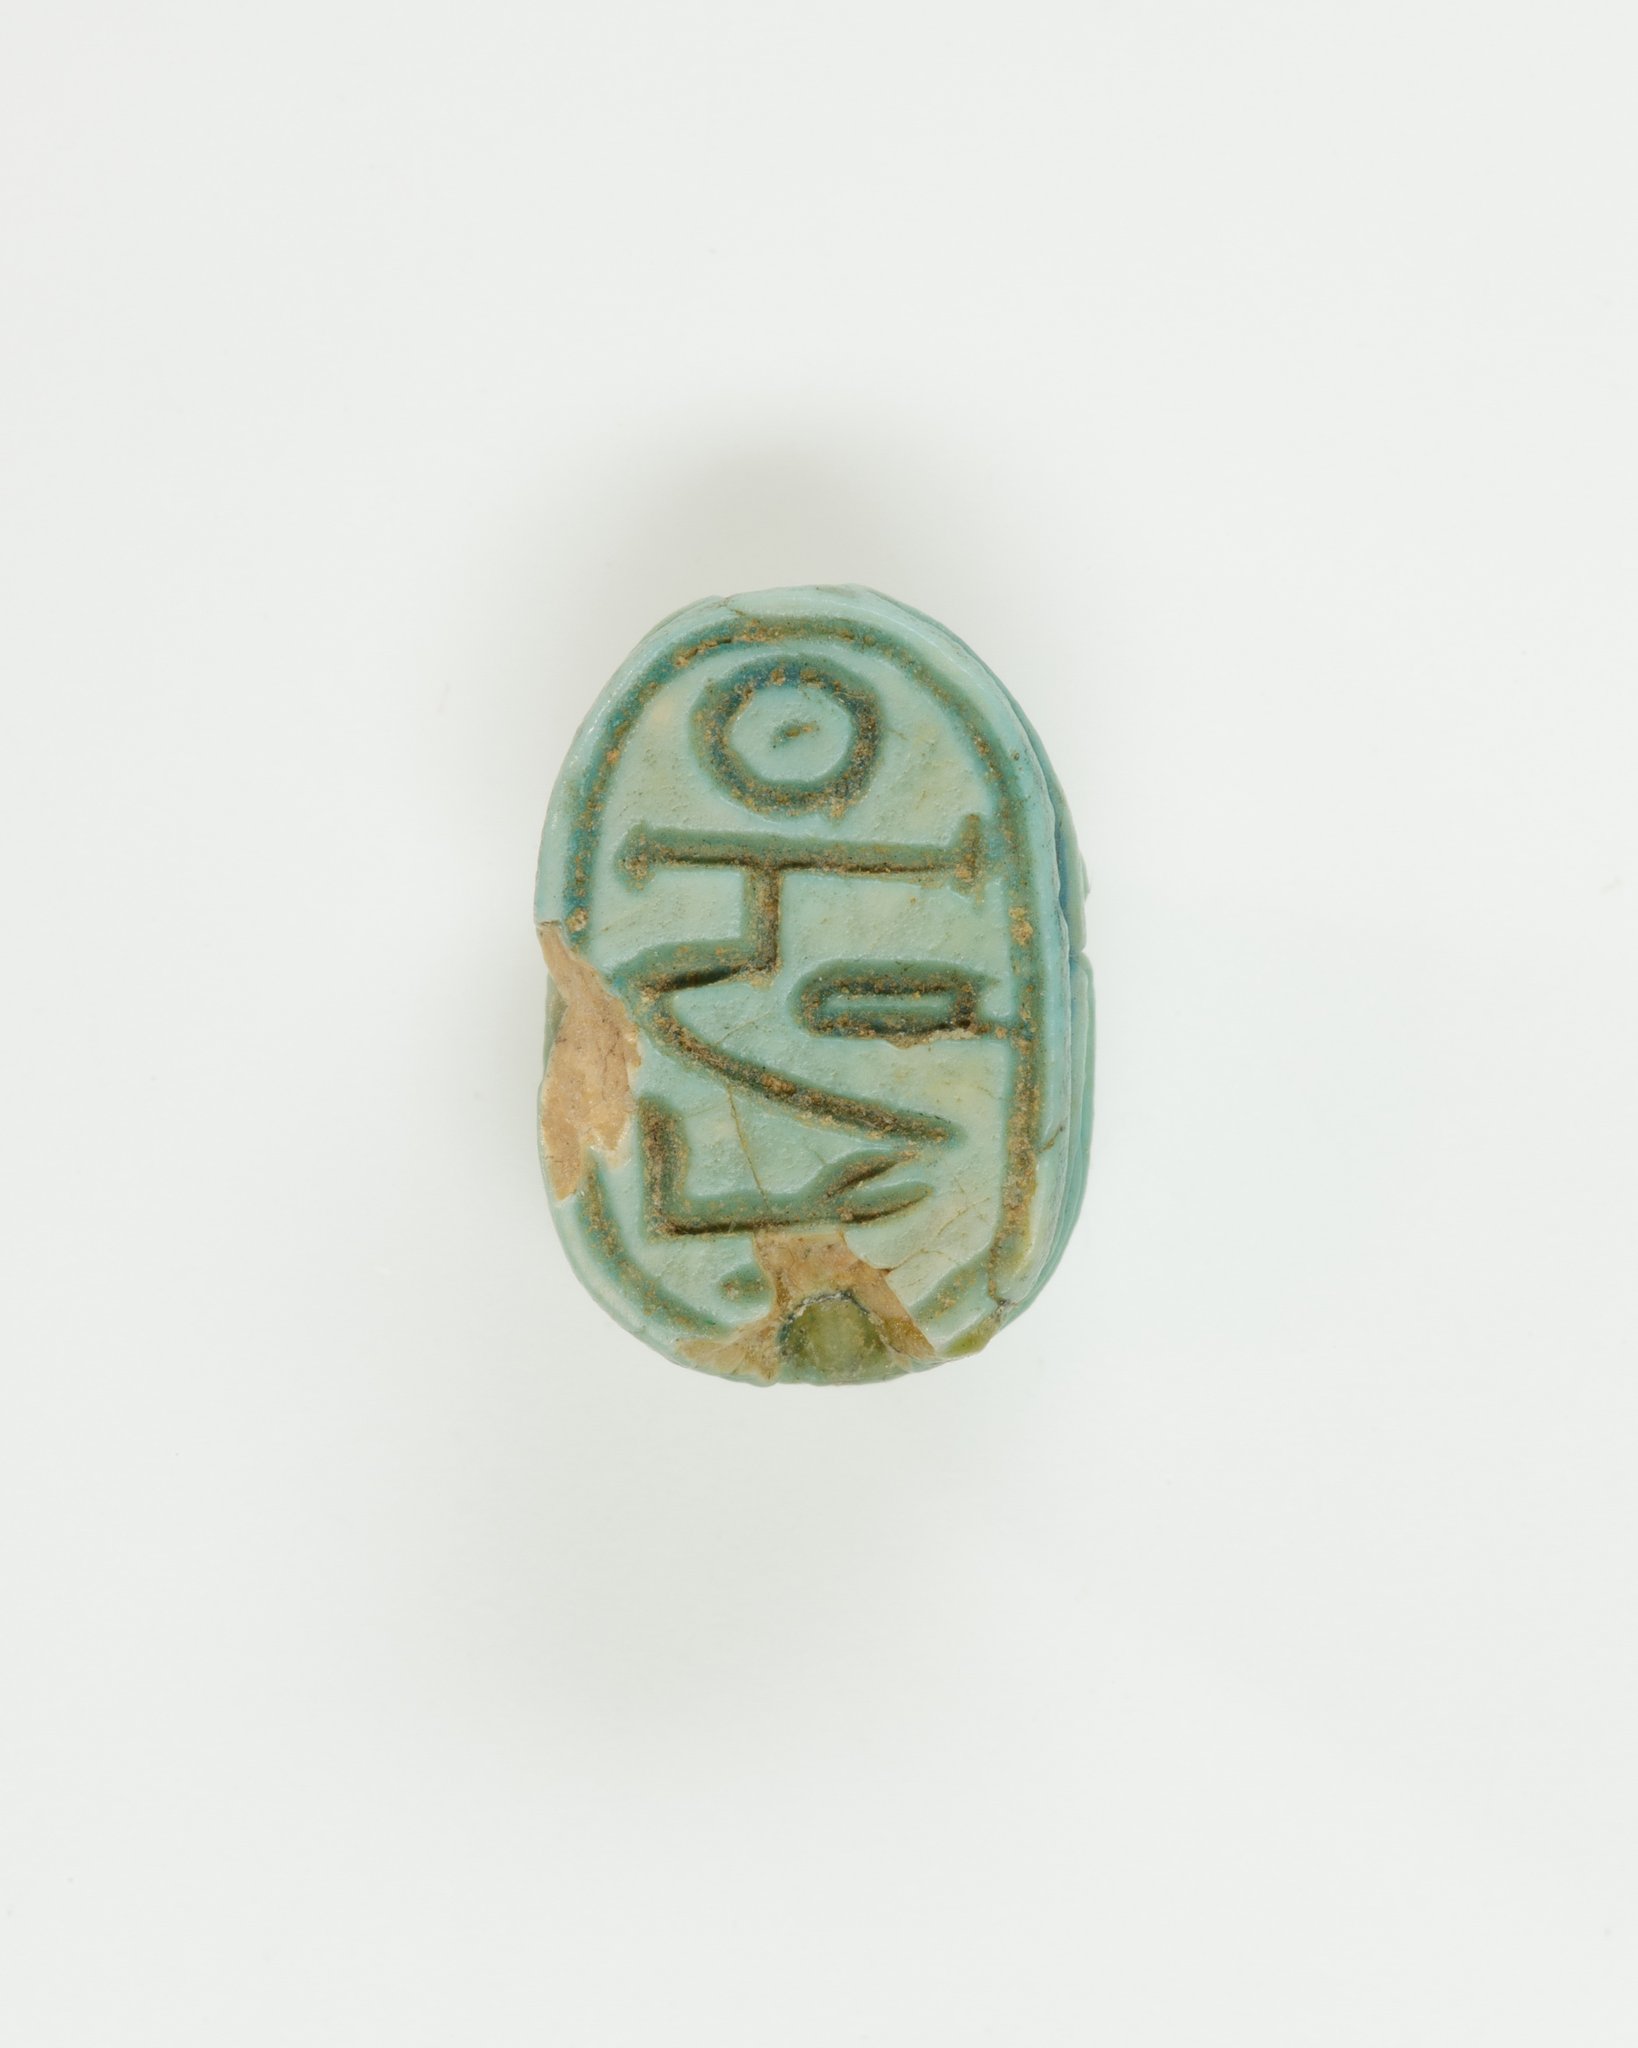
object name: scarab, amenemhat iii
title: Scarab of Amenemhat III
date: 1859-1813 BCE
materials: stone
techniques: glazing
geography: egypt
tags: scarabs